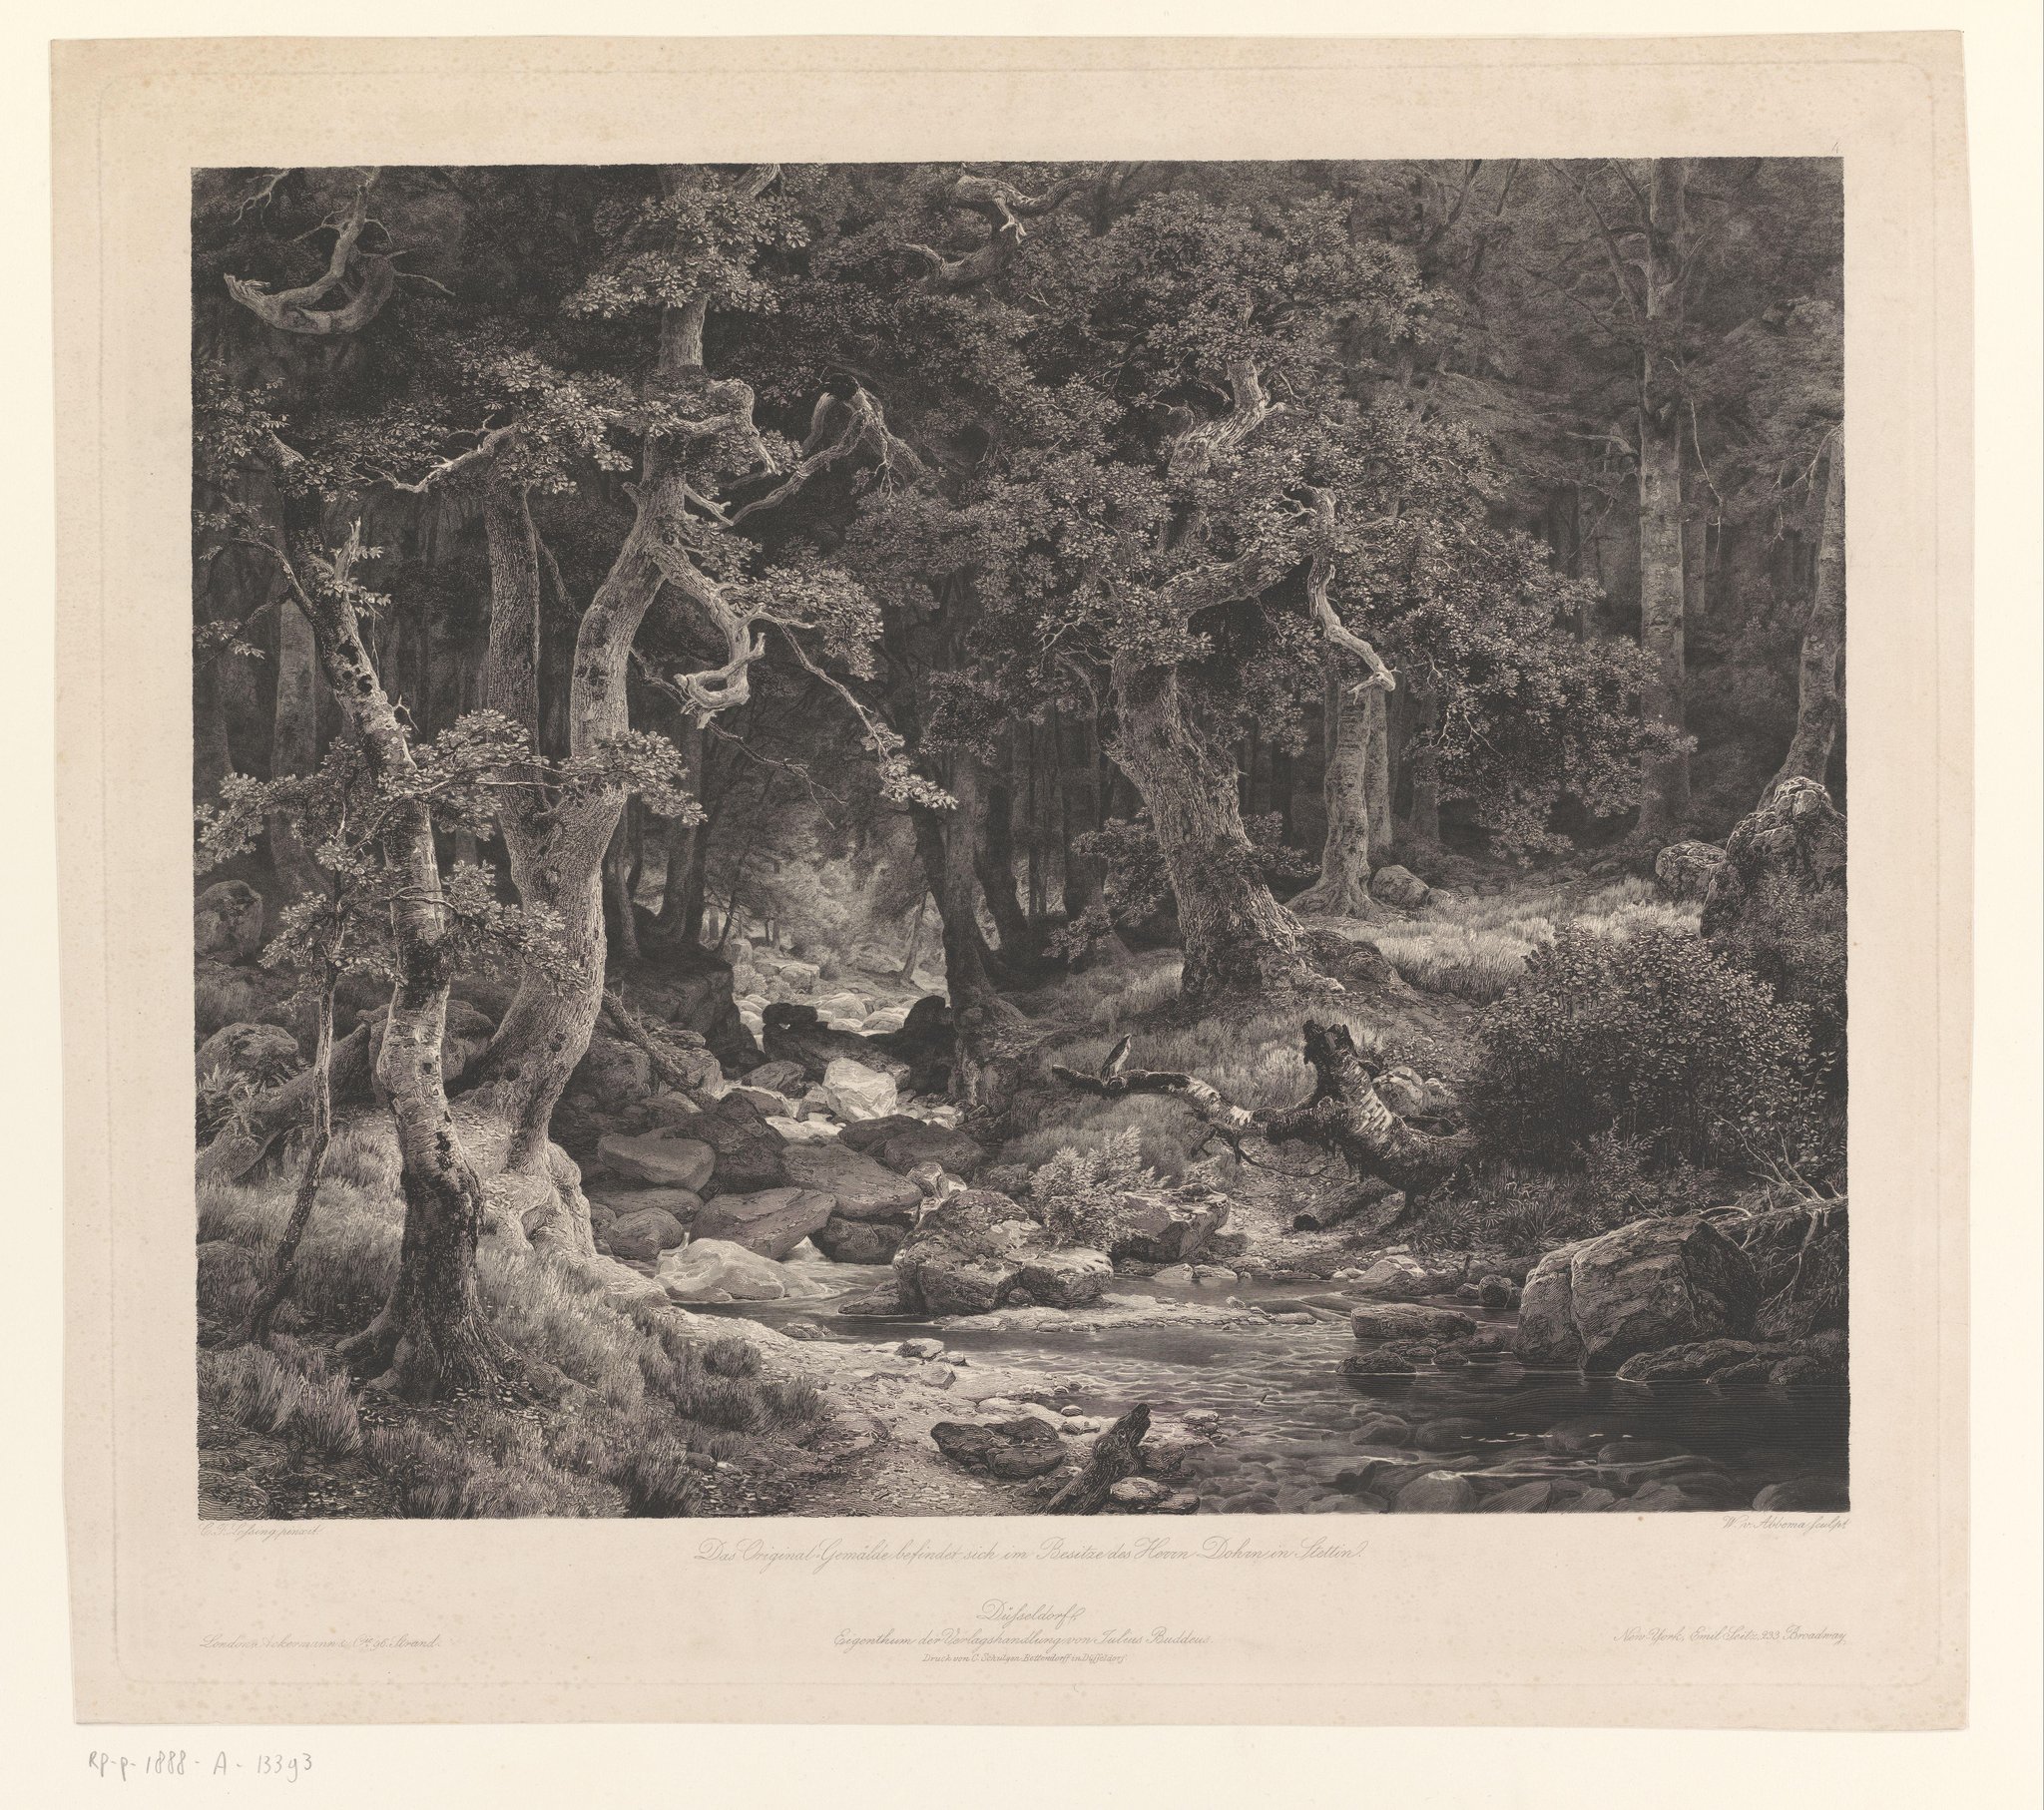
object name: print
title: Bosgezicht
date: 1822-1888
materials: paper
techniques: engraving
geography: new york city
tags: forest, wood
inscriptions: collector's mark: Lugt 2228